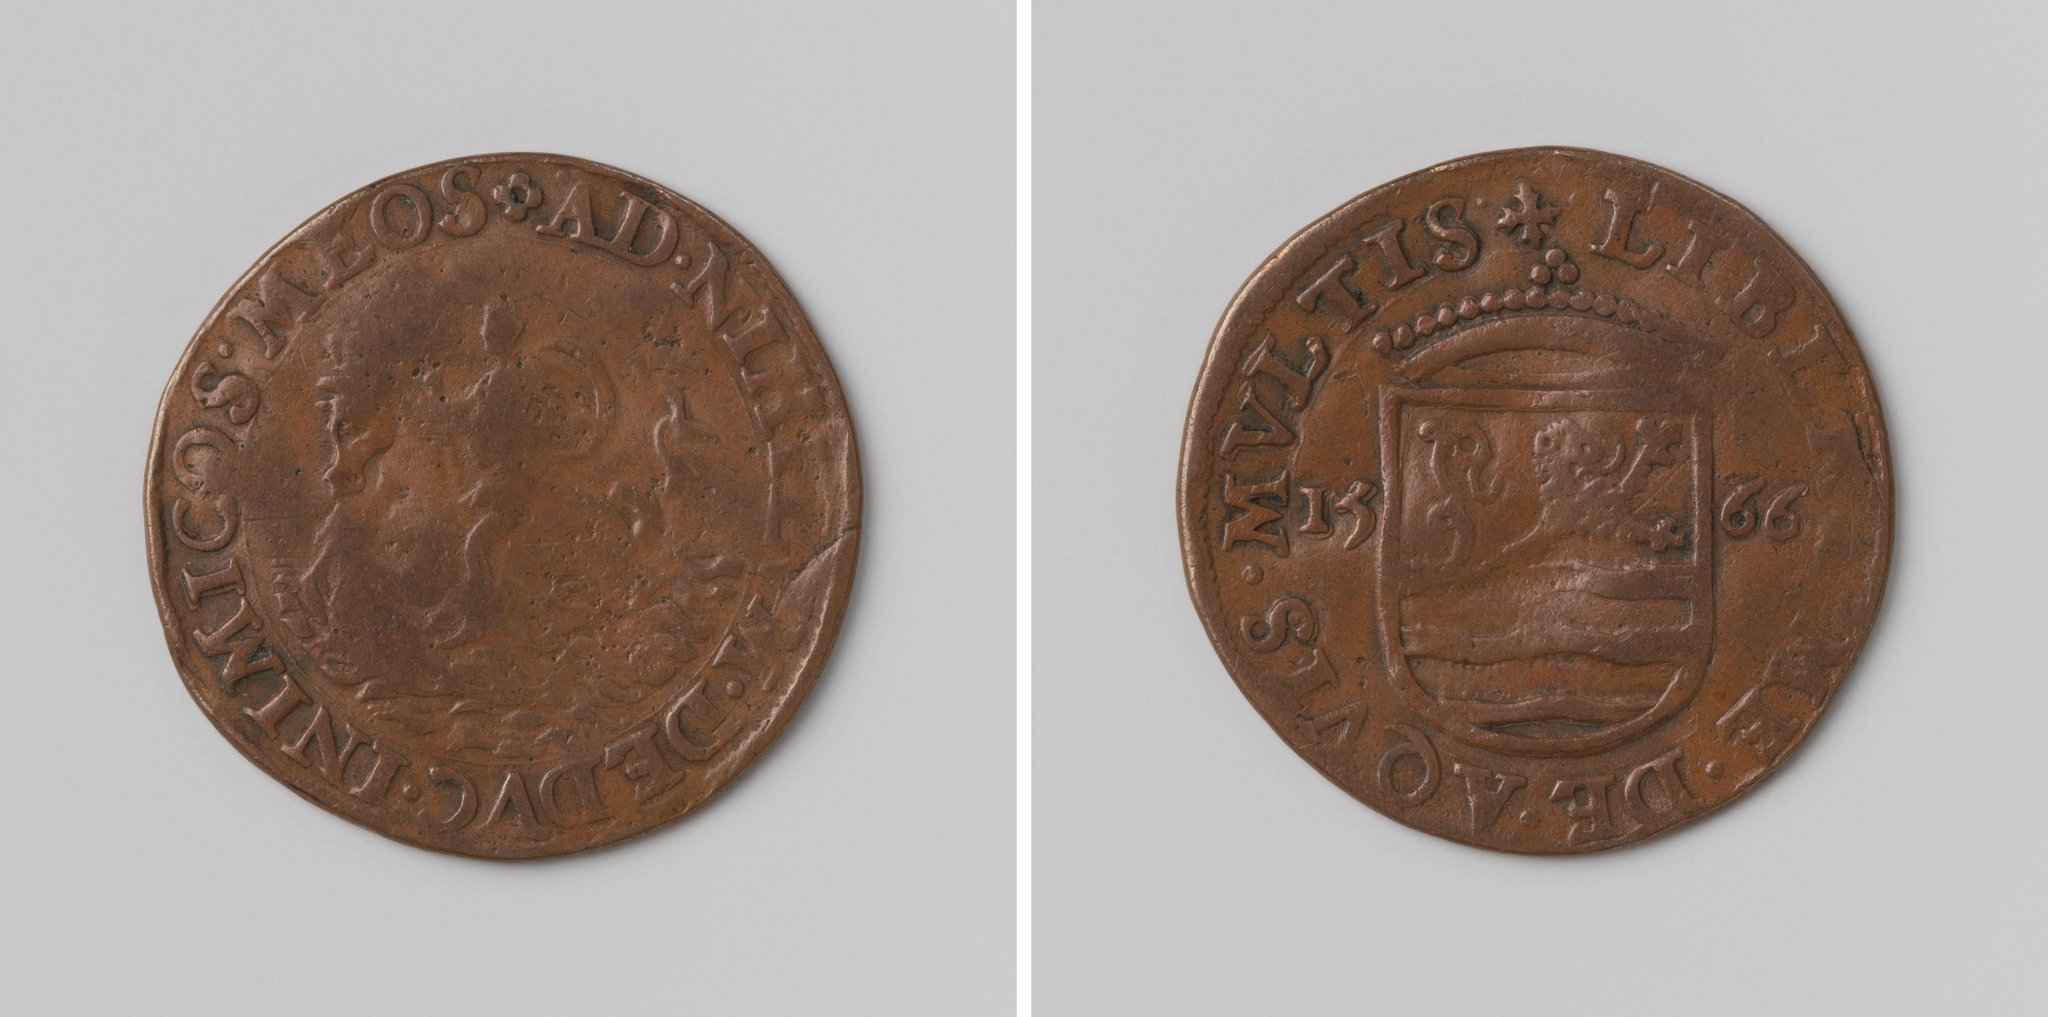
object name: jeton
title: Vrees voor de komend onderdrukking, penning geslagen door de Staten van Zeeland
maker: Anonymous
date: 1566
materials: copper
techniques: striking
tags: zeeland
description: Penning. Voorzijde: man met kroon en scepter, zittend op paard midden in water binnen omschrift. Keerzijde: gekroond wapenschild tussen jaartal binnen omschrift.